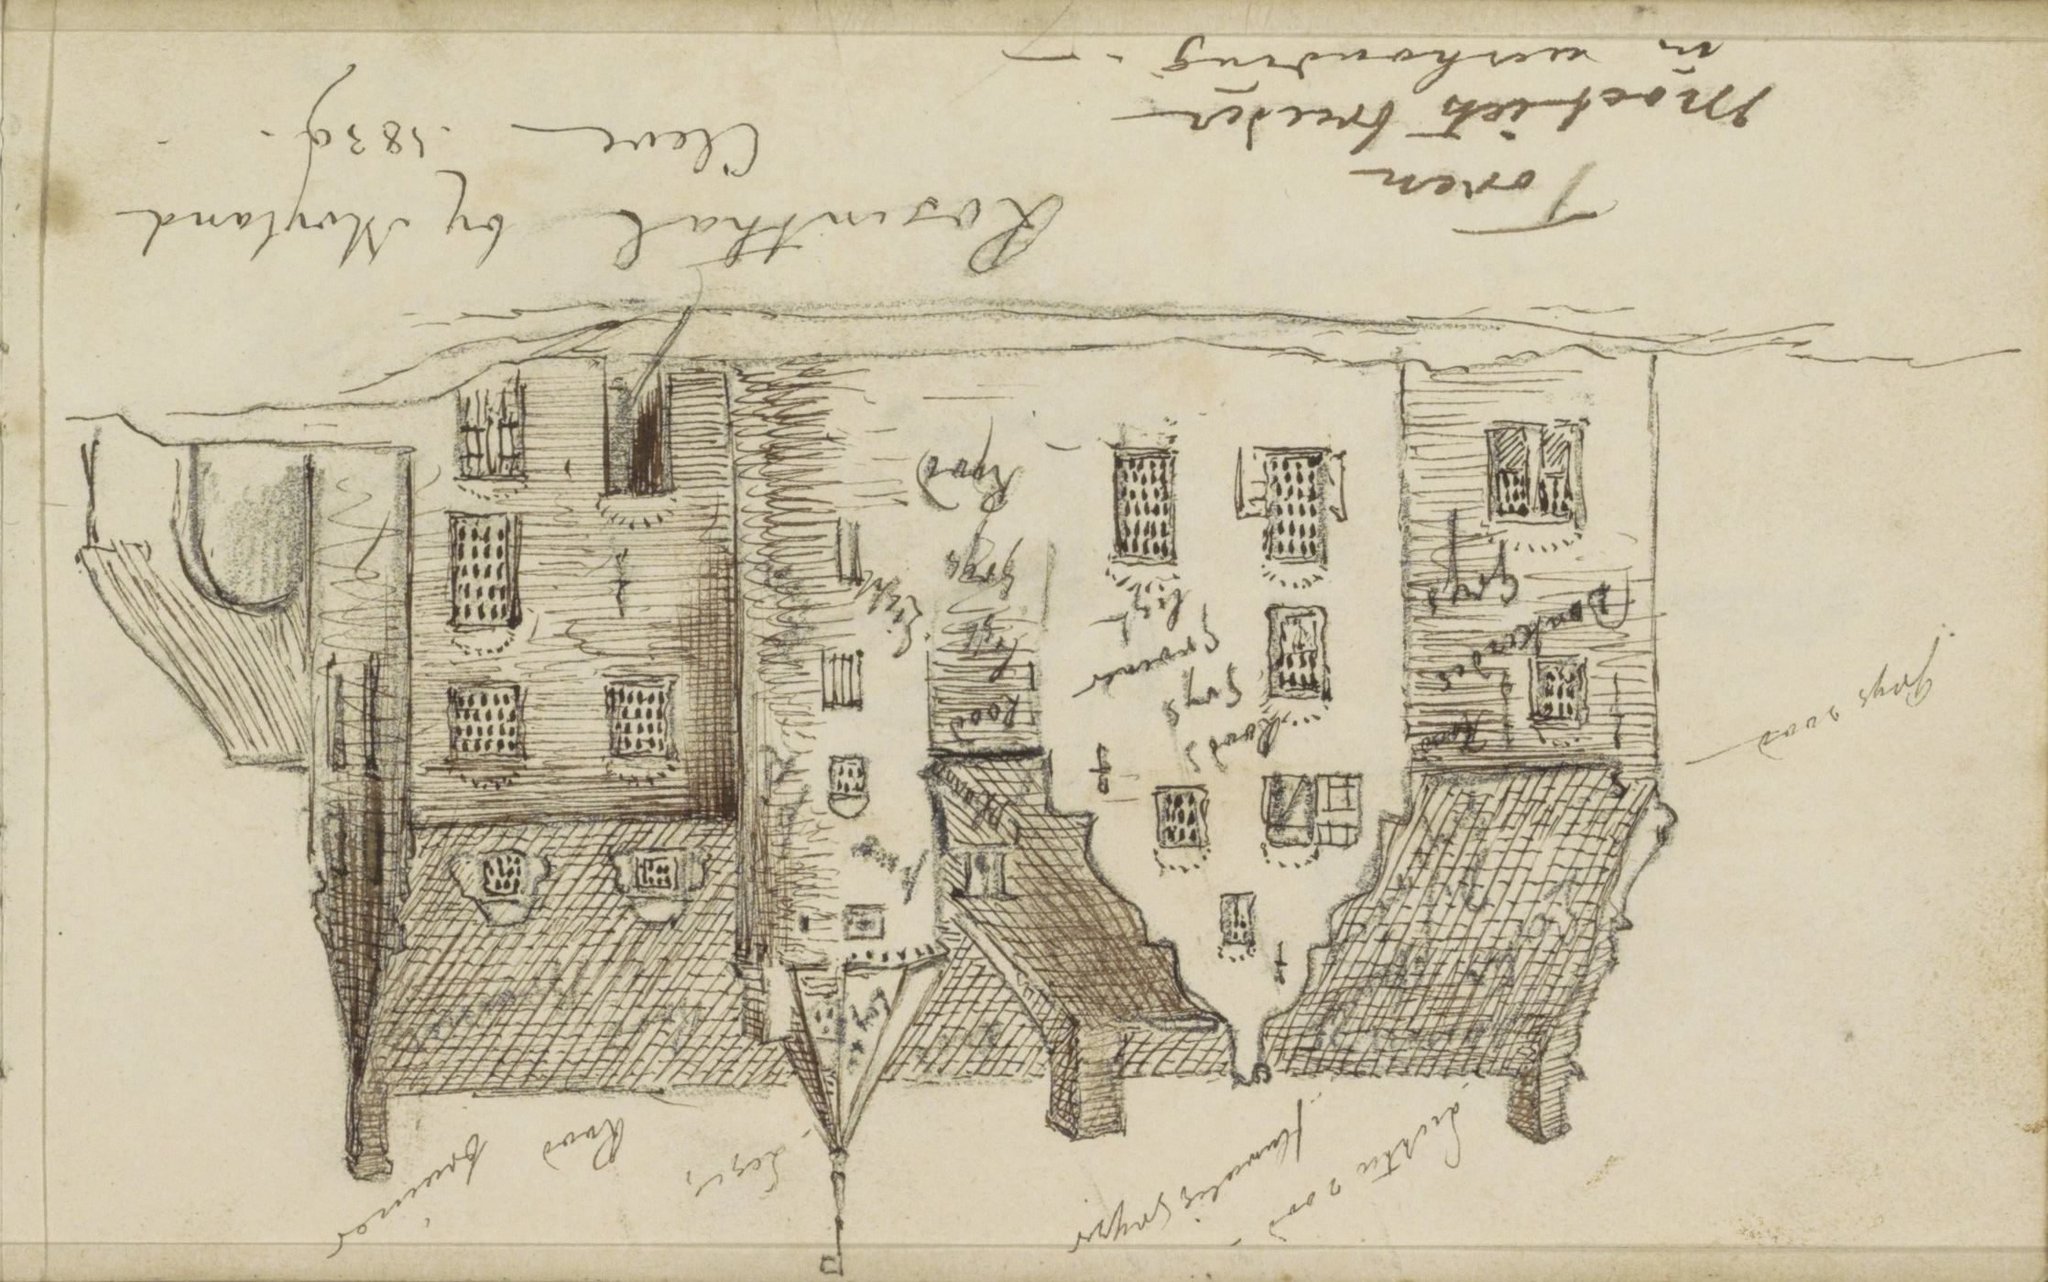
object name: sketchbook leaf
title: Slot Rosenthal in Moyland bij Kleef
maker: johannes tavenraat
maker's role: draughtsman, painter, print maker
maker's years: 1809-1881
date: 1839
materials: paper, pencil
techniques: pen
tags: castle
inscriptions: date and inscription: ‘Rosenthal bij Moyland/ Cleve 1839./ Toren/ moet iets breeder/ in verhouding.-’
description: Blad 36 recto uit een schetsboek met 37 bladen.